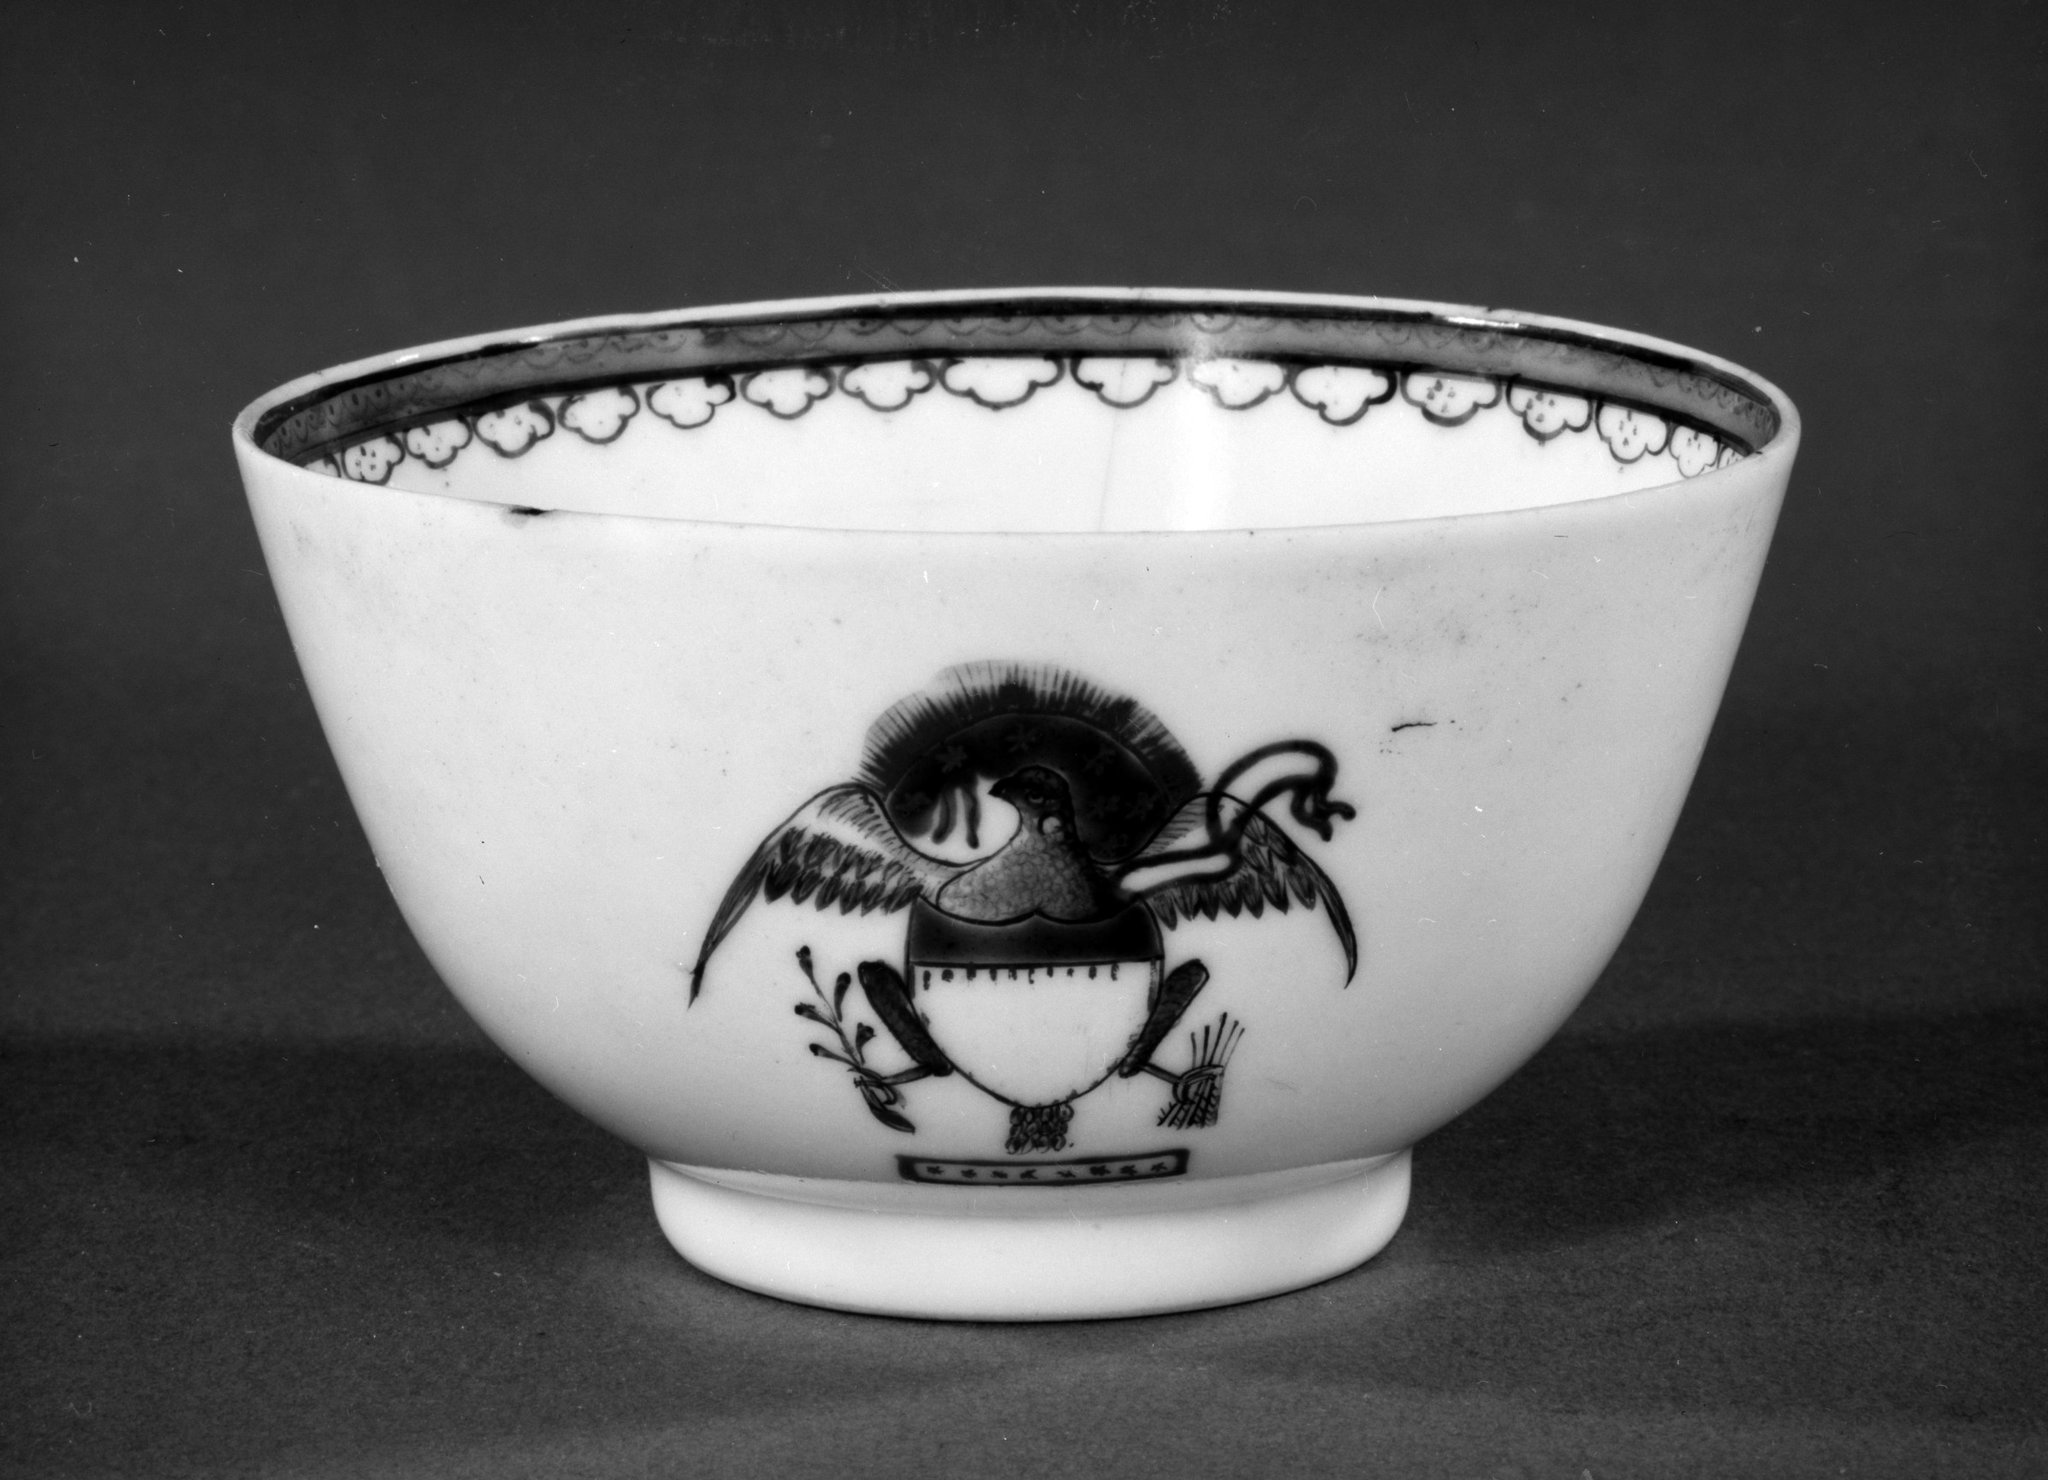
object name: cup and saucer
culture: chinese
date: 1700-1800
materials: porcelain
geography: china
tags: eagles